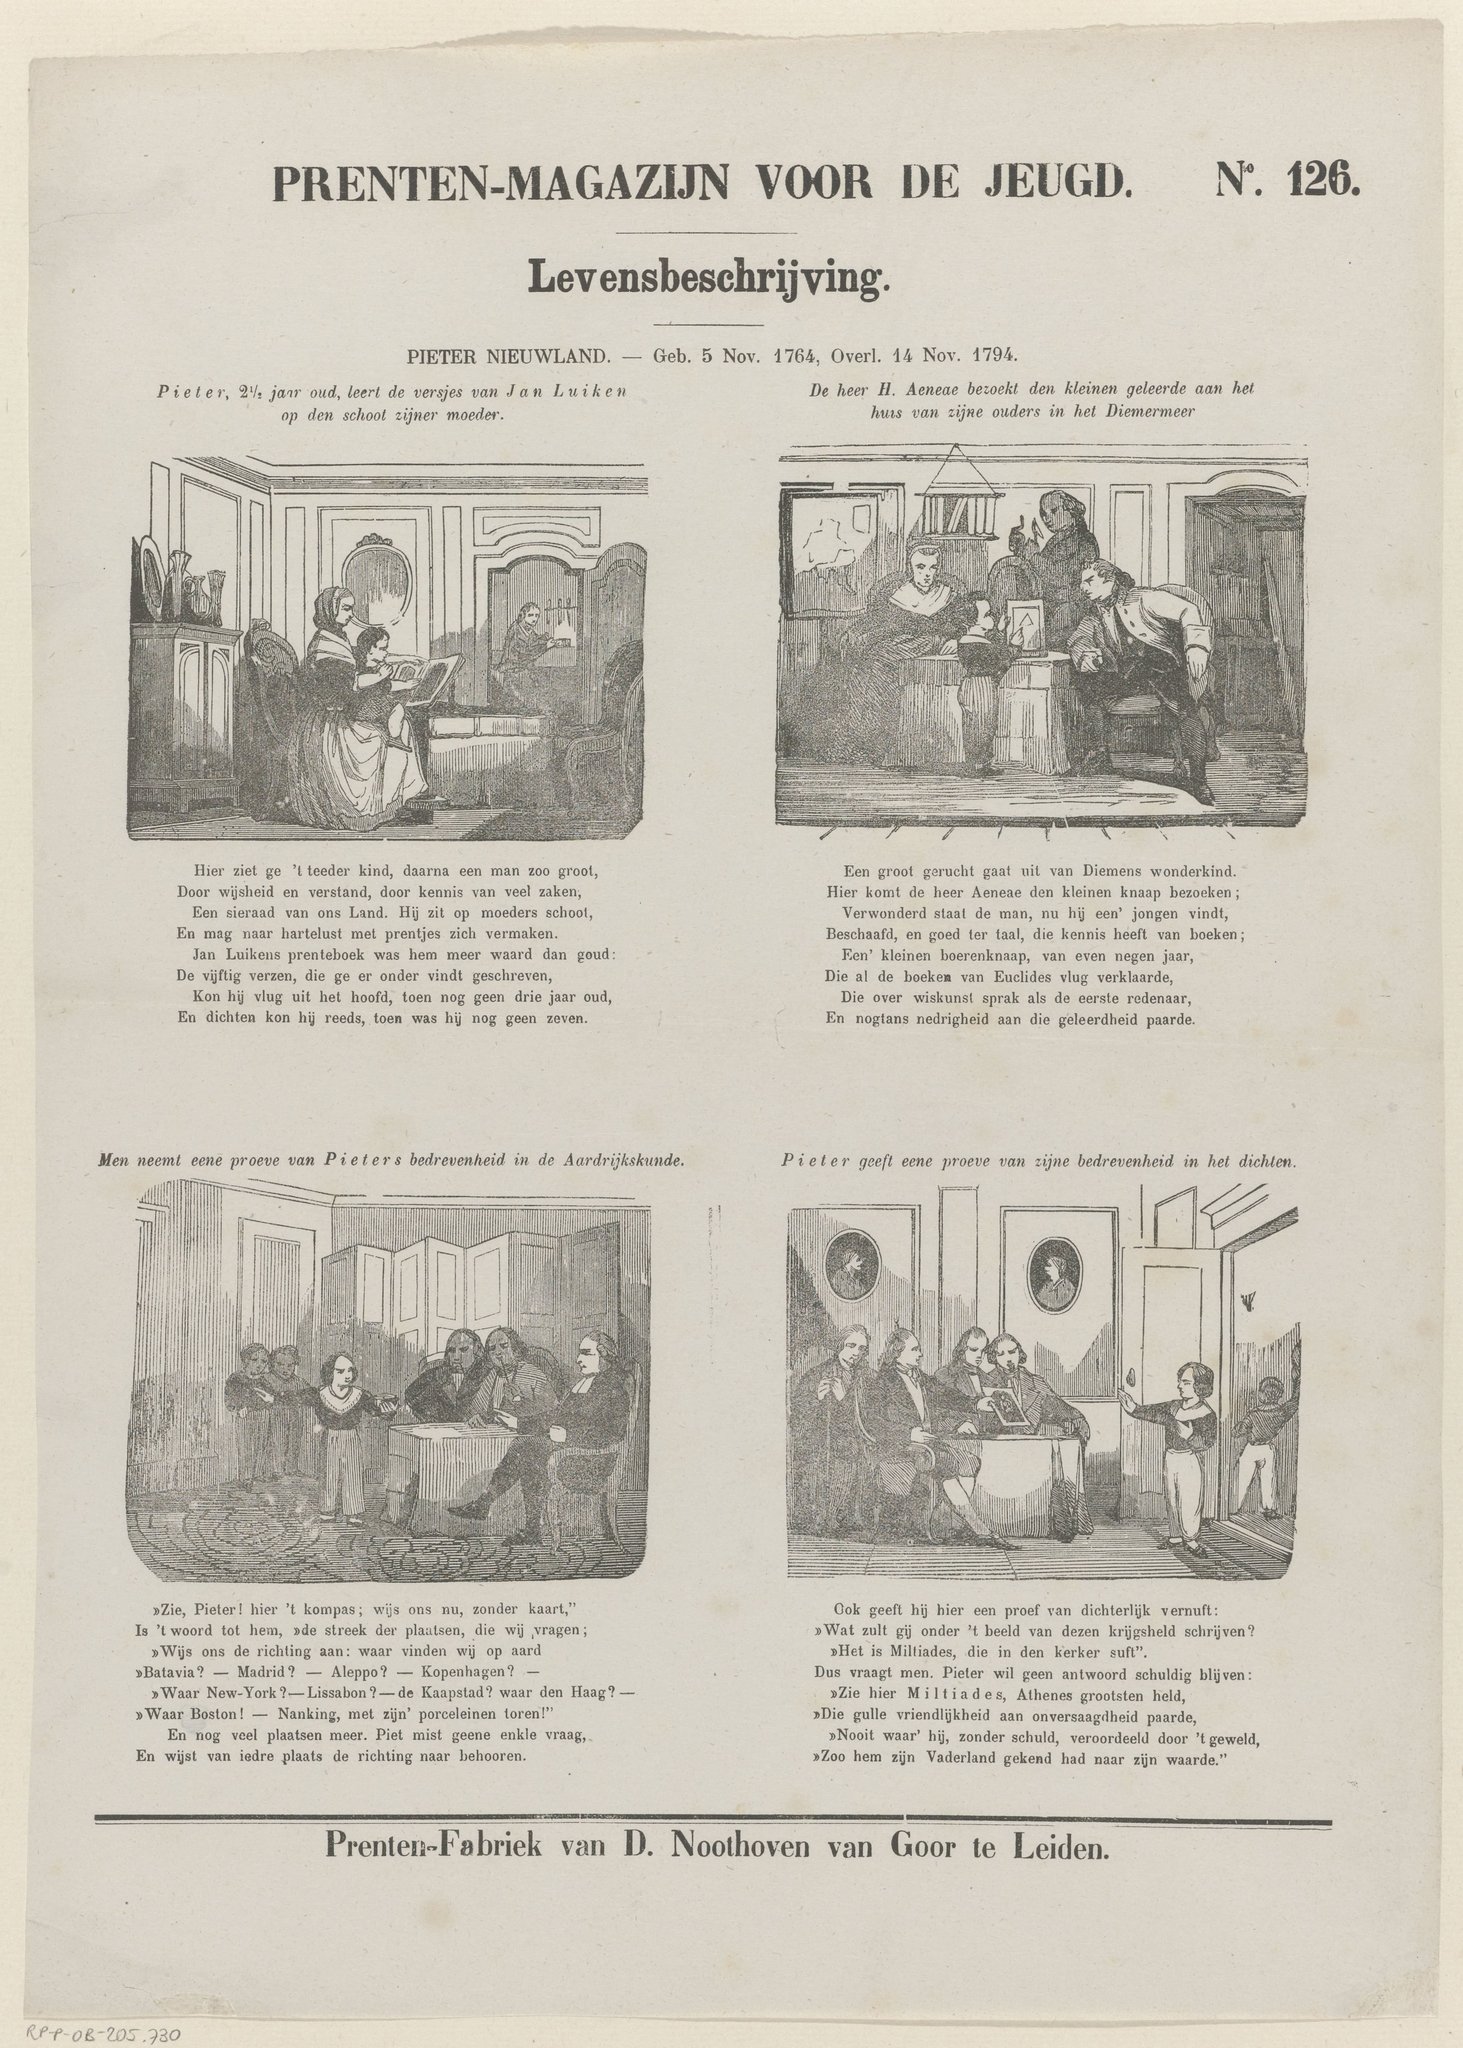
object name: print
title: Pieter Nieuwland. - Geb. 5 Nov. 1764, Overl. 14 Nov. 1794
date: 1850-1881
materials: paper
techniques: letterpress printing, engraving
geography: leiden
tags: hendrik aeneae, amsterdam, print maker, draughtsman, jan luyken, education, science and learning, child, historical persons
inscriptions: collector's mark: Lugt 2760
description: Blad met 4 voorstellingen uit het leven van Pieter Nieuwland. Boven elke afbeelding een titel, onder elke afbeelding een achtregelig vers. Genummerd rechtsboven: No. 126.